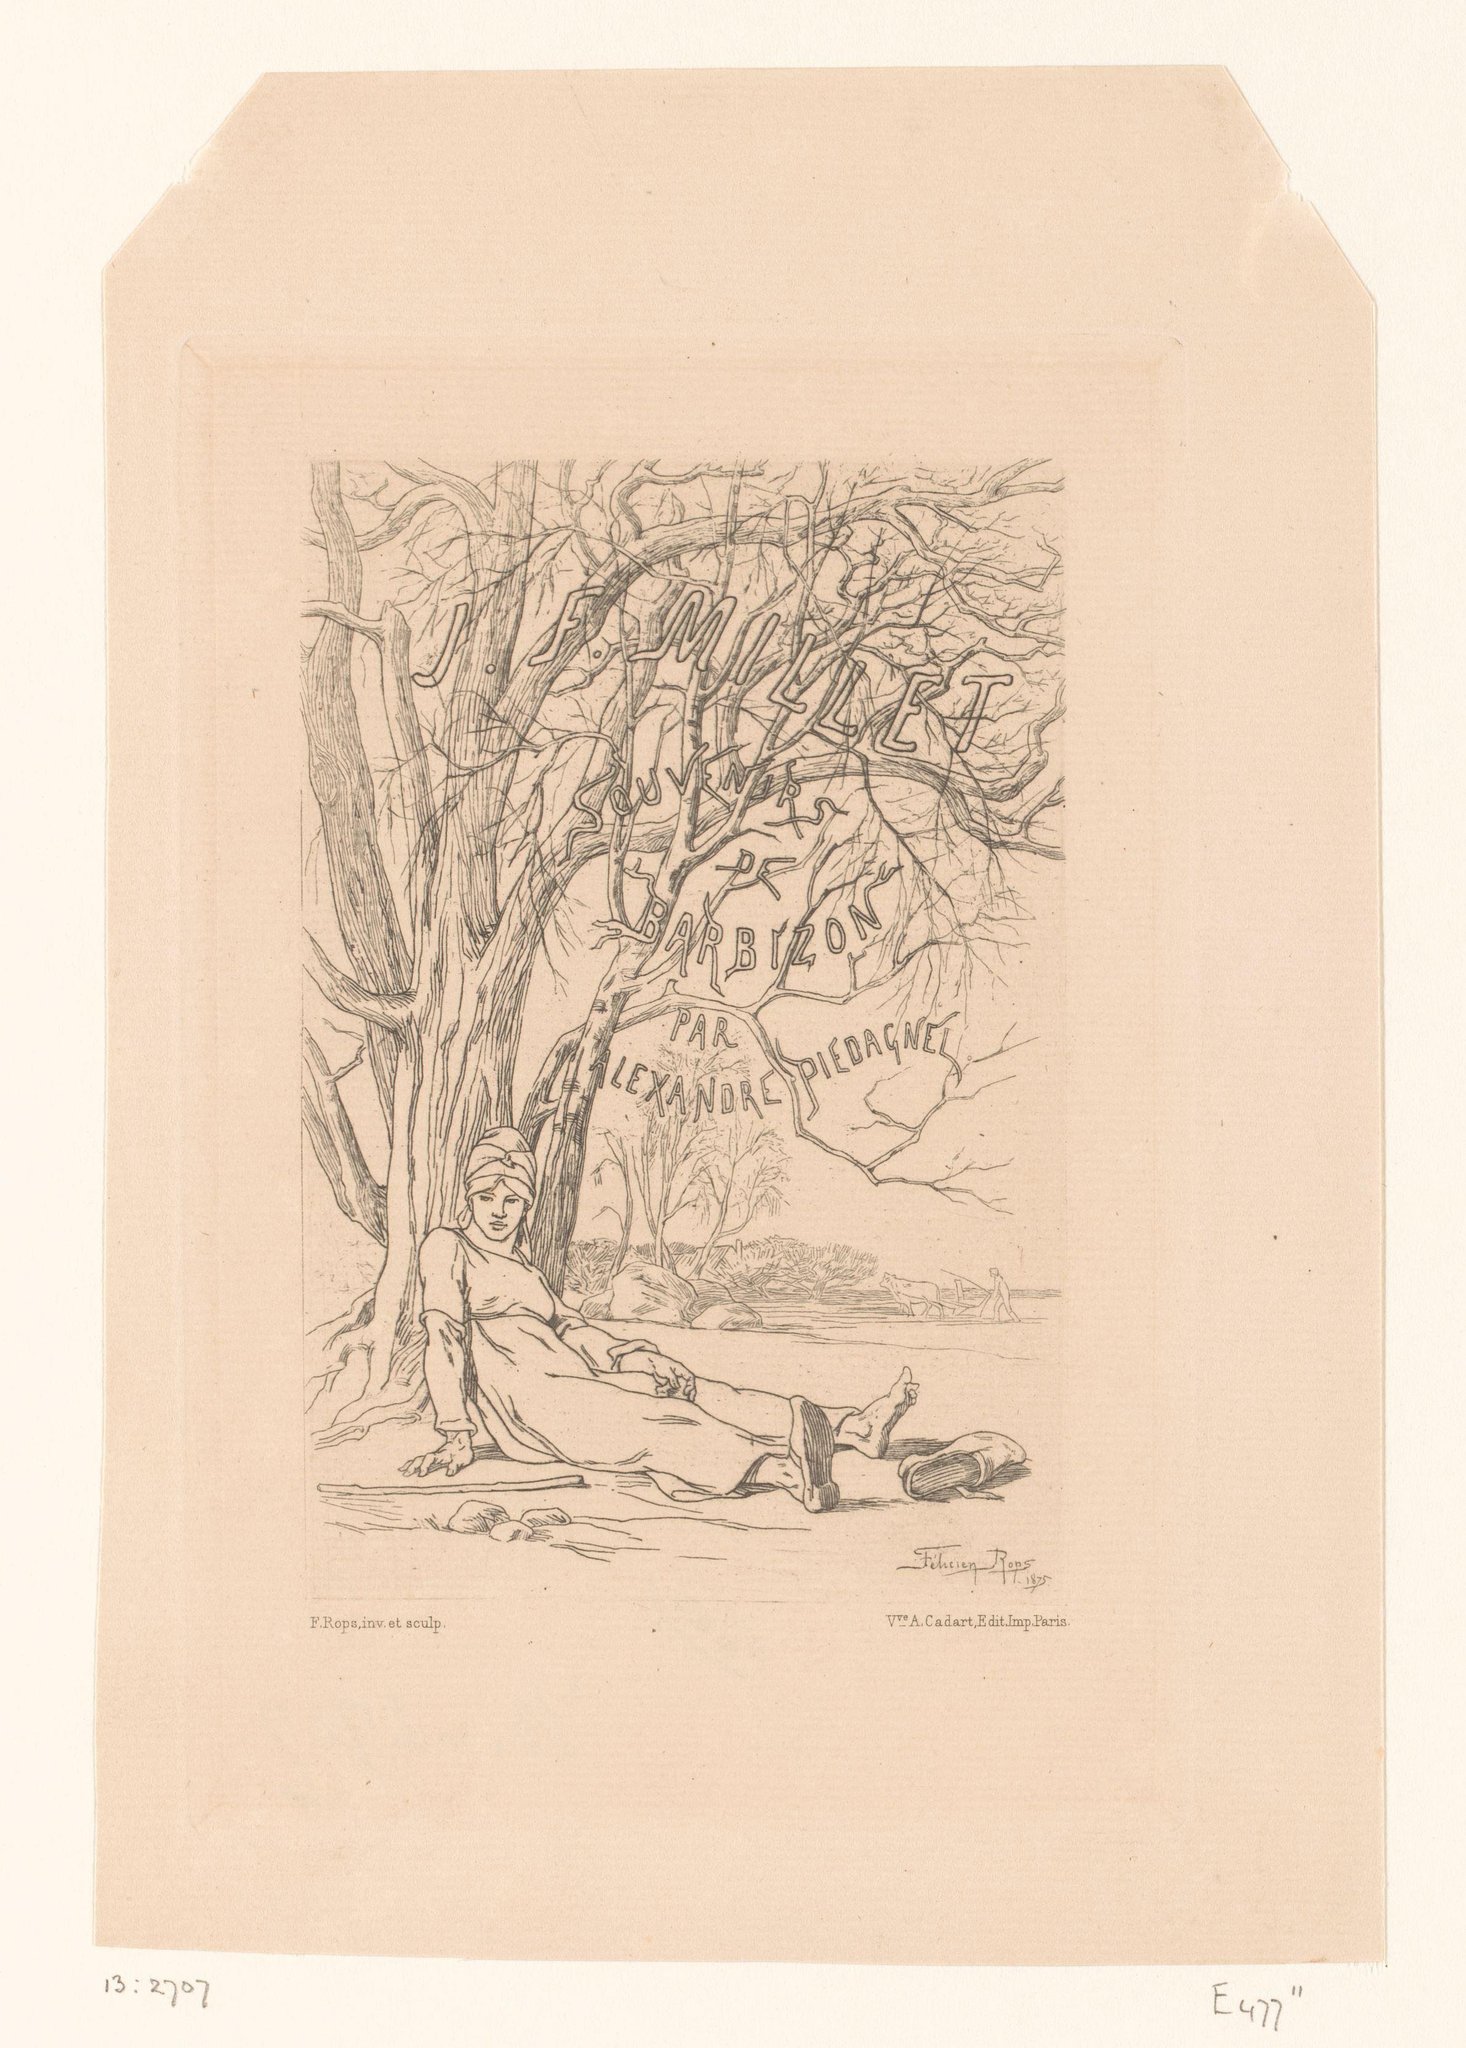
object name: book illustration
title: Vrouw op klompen ligt onder een boom te rusten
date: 1875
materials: paper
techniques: photoaquatint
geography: paris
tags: adult woman, ploughing, resting - bb - out of doors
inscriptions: collector's mark: Lugt 2228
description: Prent uit: Piednagel, Alexandre. J.F. Millet, Souvenirs de Barbizon. Paris: weduwe Alfred Cadart, 1876.